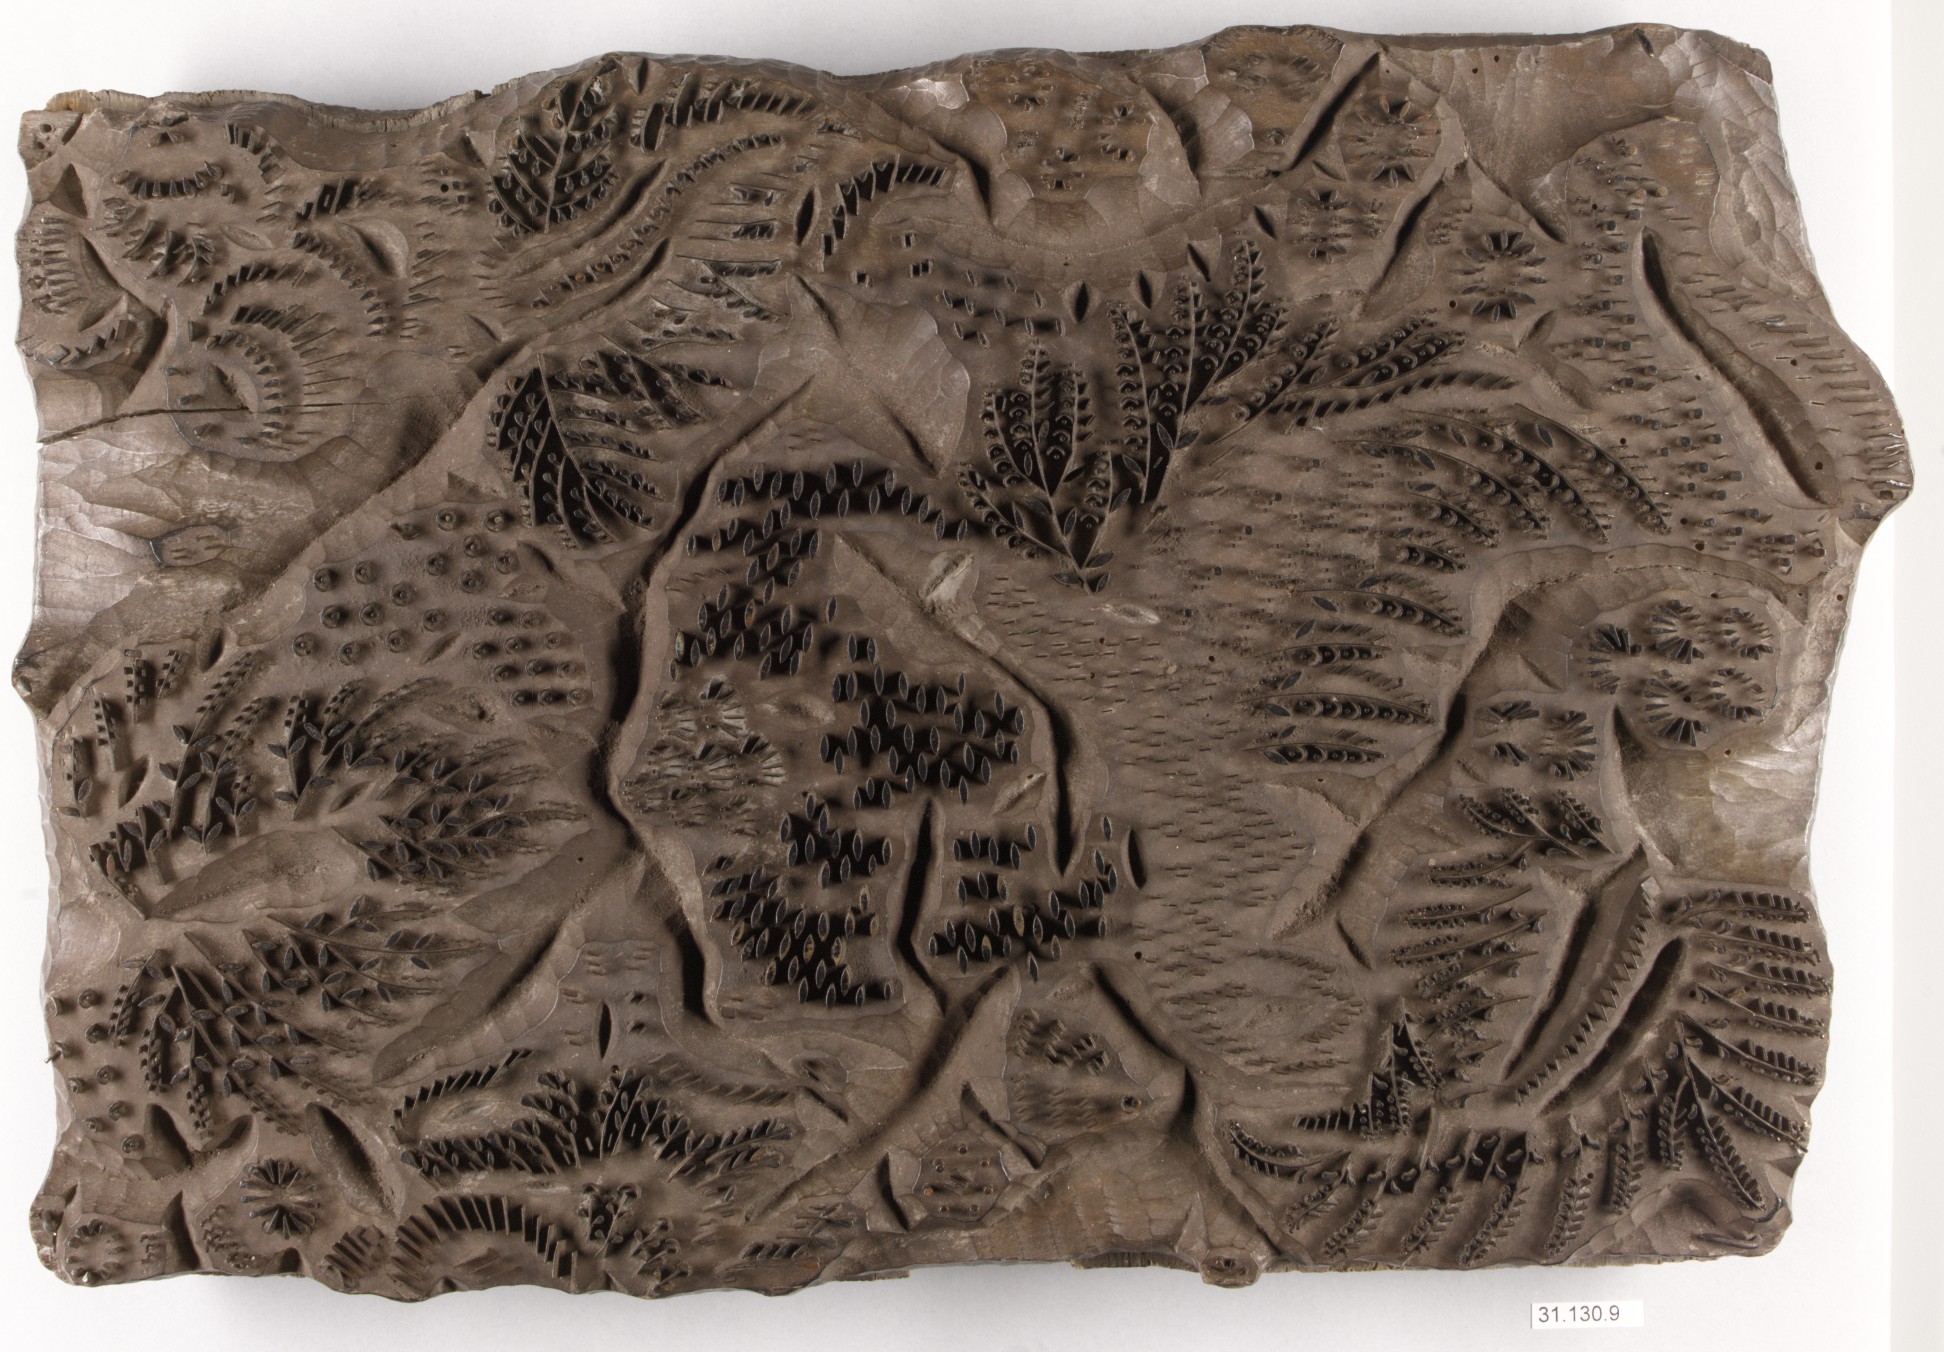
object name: woodblock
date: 1701-1900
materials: metal, wood